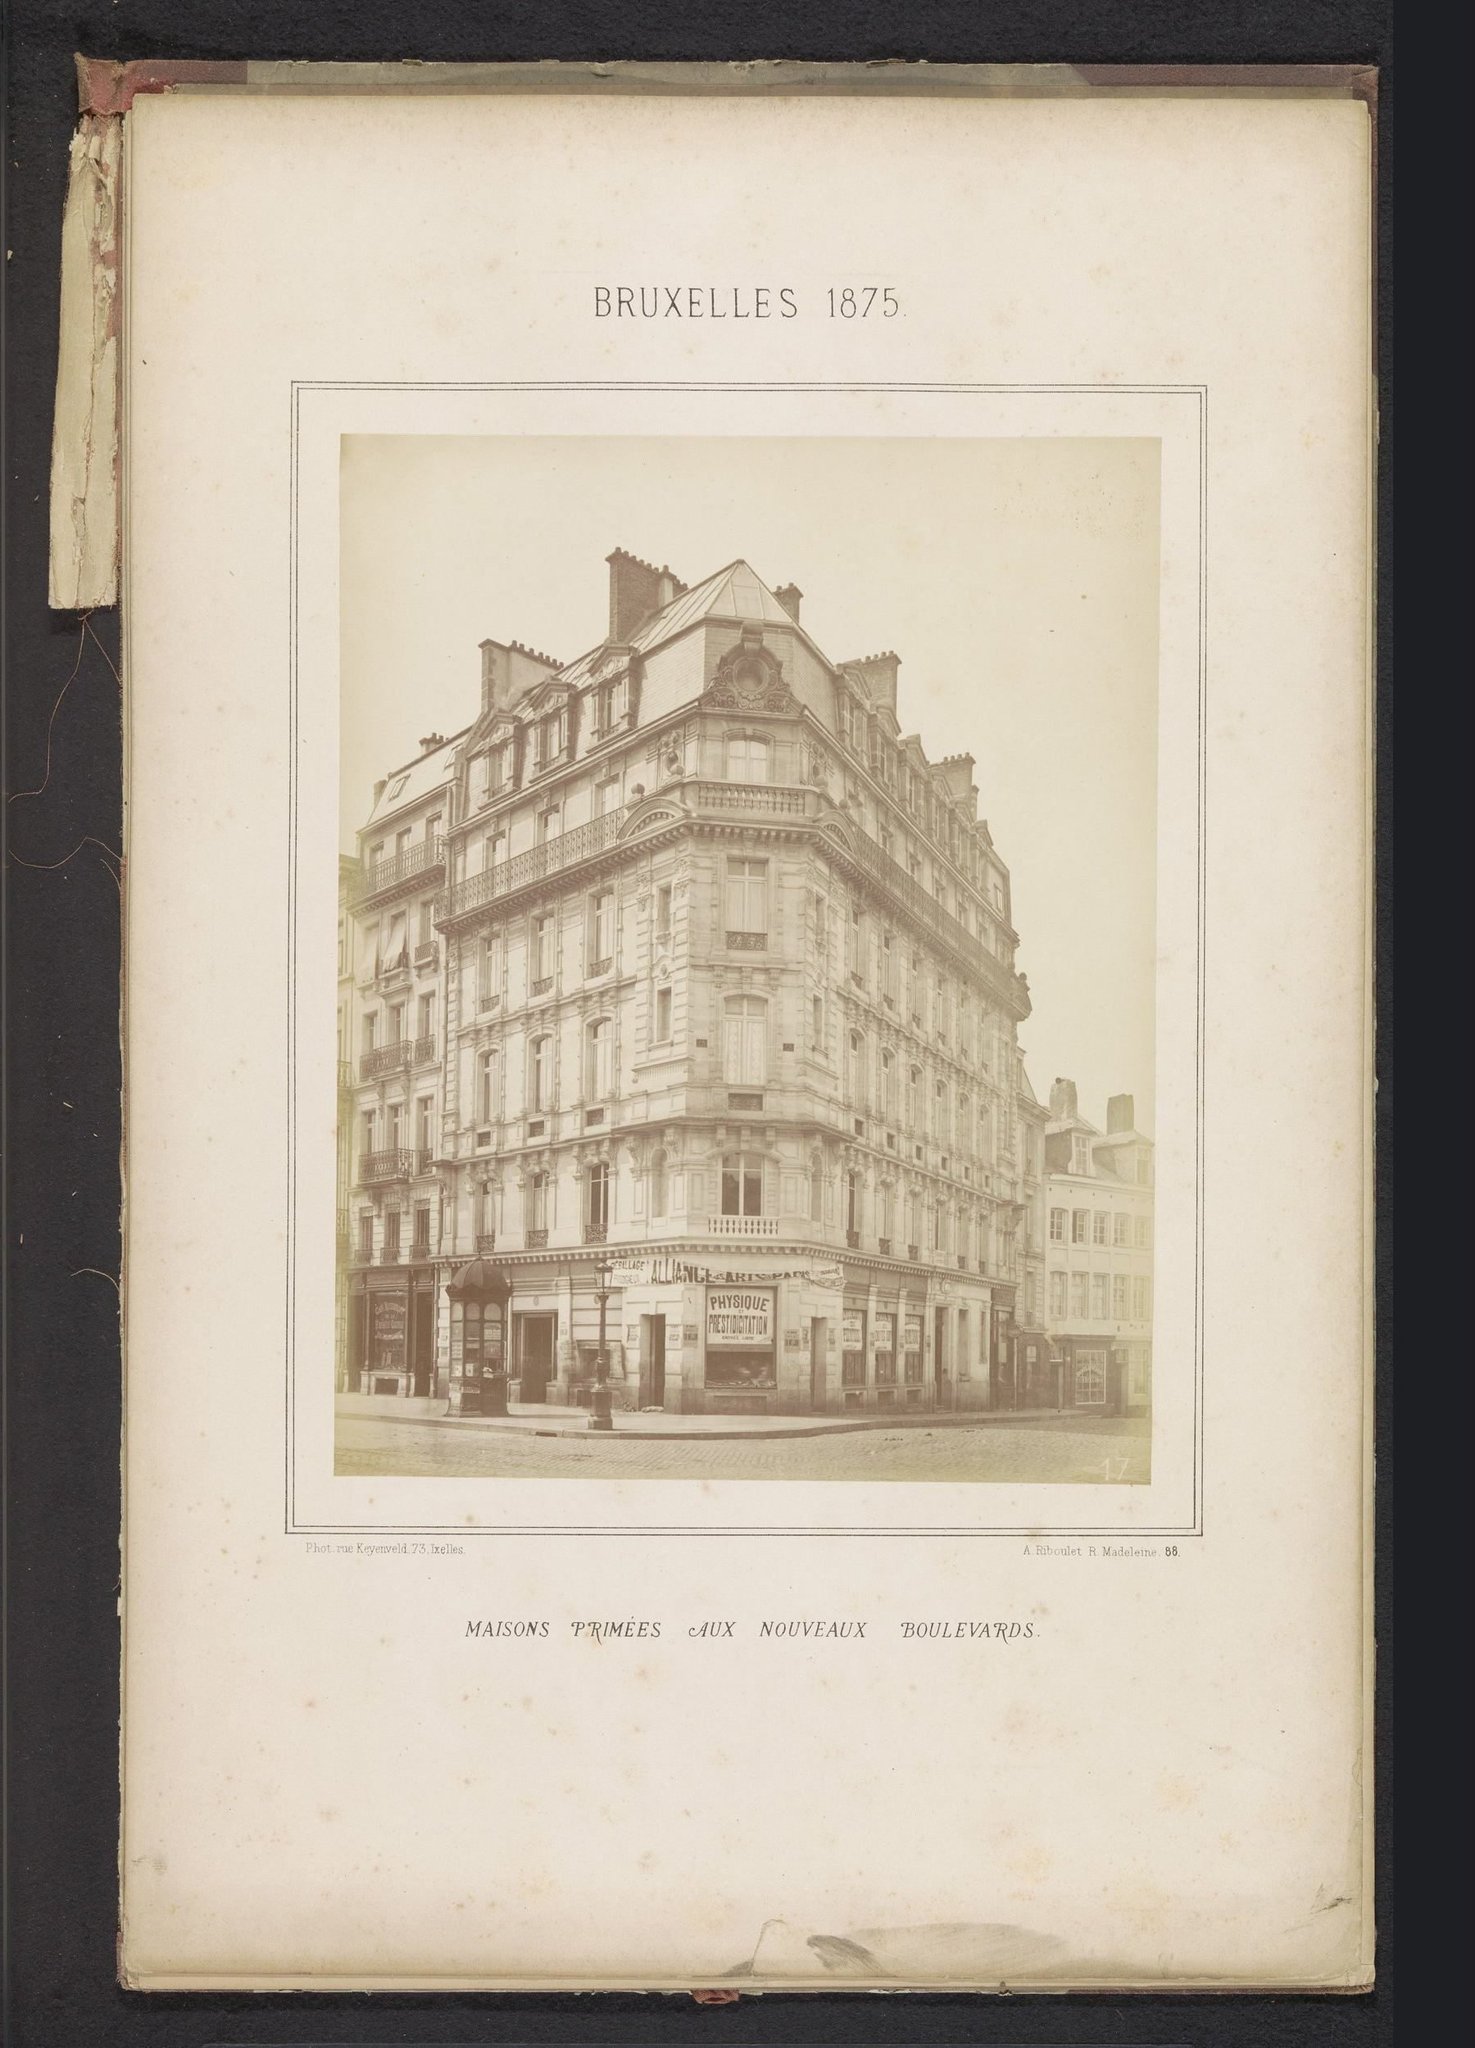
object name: photograph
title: Maisons primées aux nouveaux boulevards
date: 1875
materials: photographic support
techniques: albumen print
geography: brussels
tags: housing, avenue, boulevard, promenade, esplanade, façade (of house or building)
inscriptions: number: ‘17’